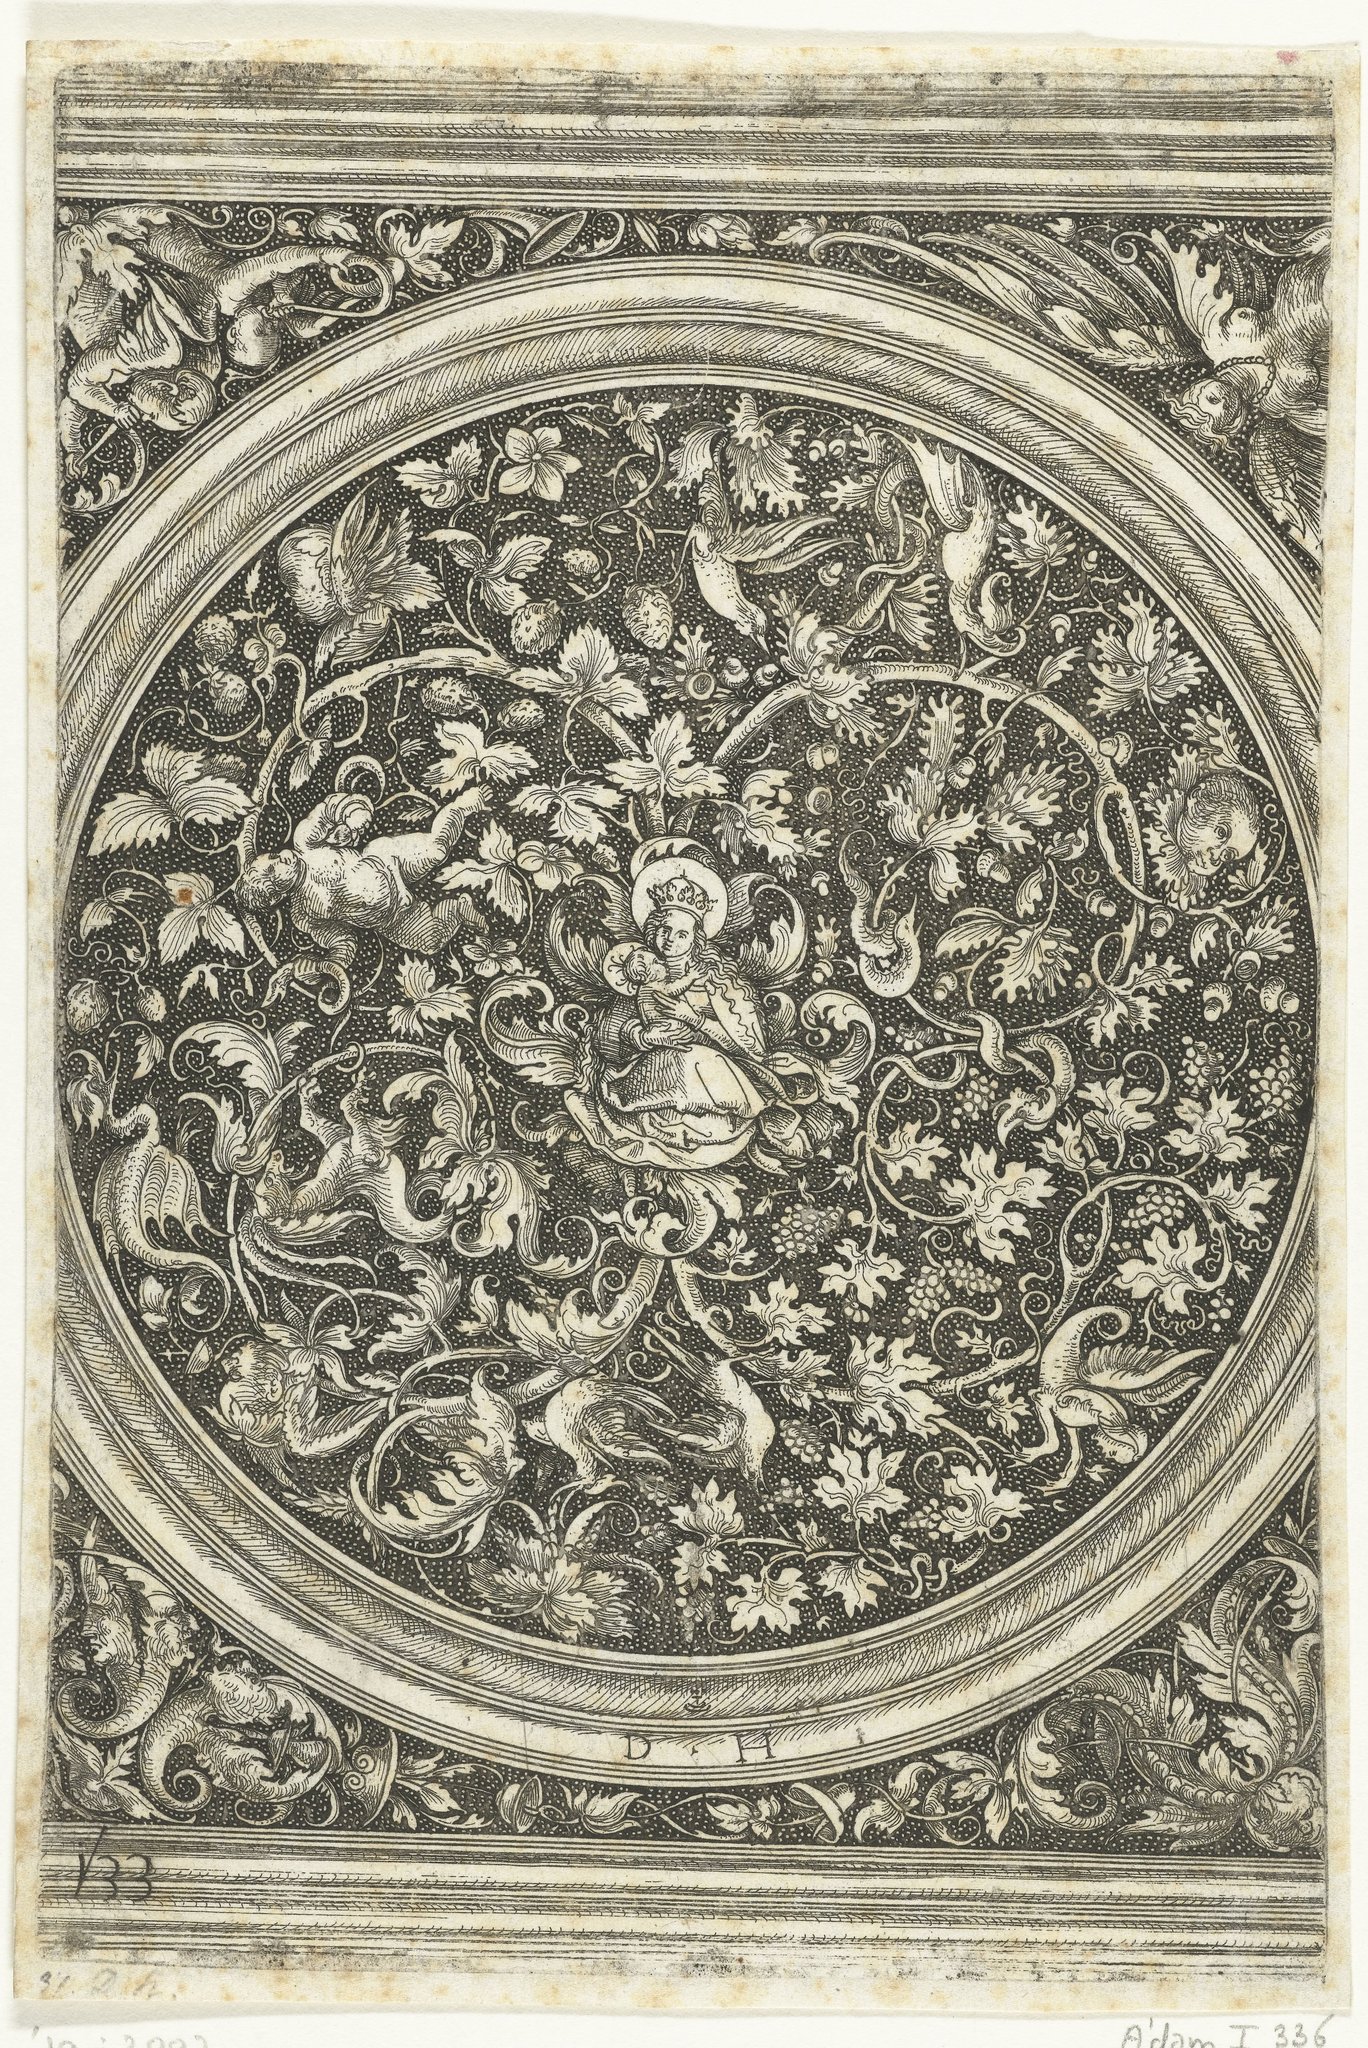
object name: print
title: Medaillon met druivenranken, aardbeiplanten en grotesken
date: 1480-1536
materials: paper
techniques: etching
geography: germany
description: In het midden zit Maria met kind. De hoeken tussen het medaillon en de bladrand zijn eveneens met bladranken en grotesken gevuld.